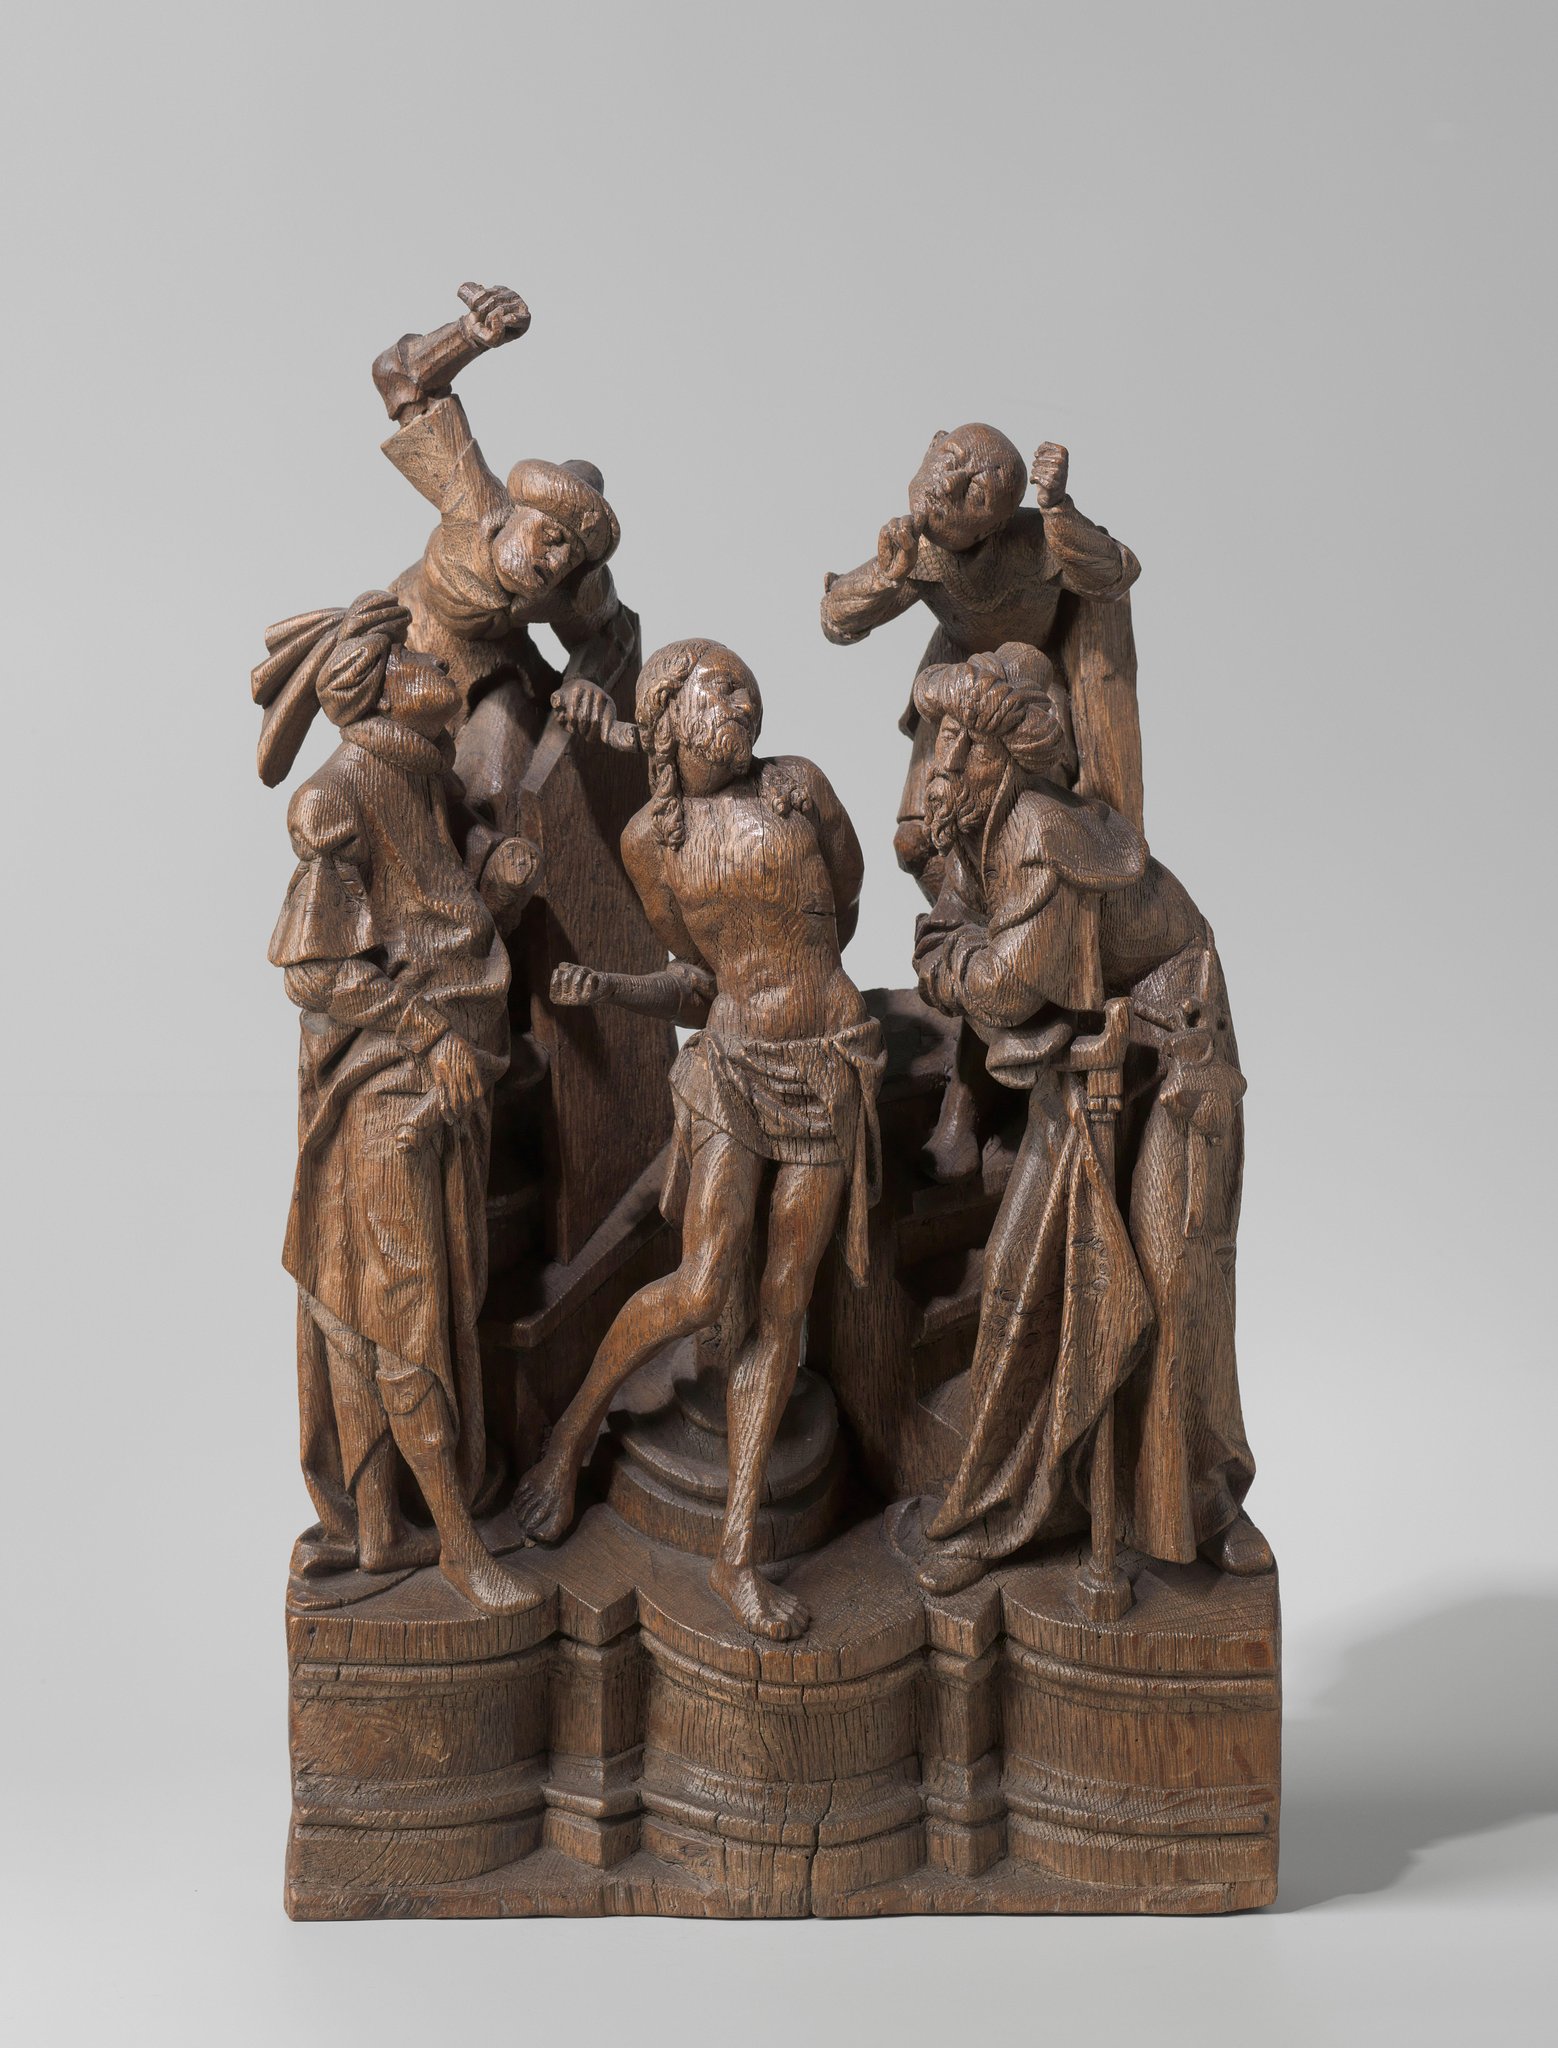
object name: sculpture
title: The Flagellation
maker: Anonymous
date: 1530-1540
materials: wood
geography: antwerp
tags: flagellation by soldiers, christ usually tied to a column (matthew 27:26; mark 15:15; john 19:1)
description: The Flagellation. Oak, originally with polychromy. Antwerp, c. 1530.